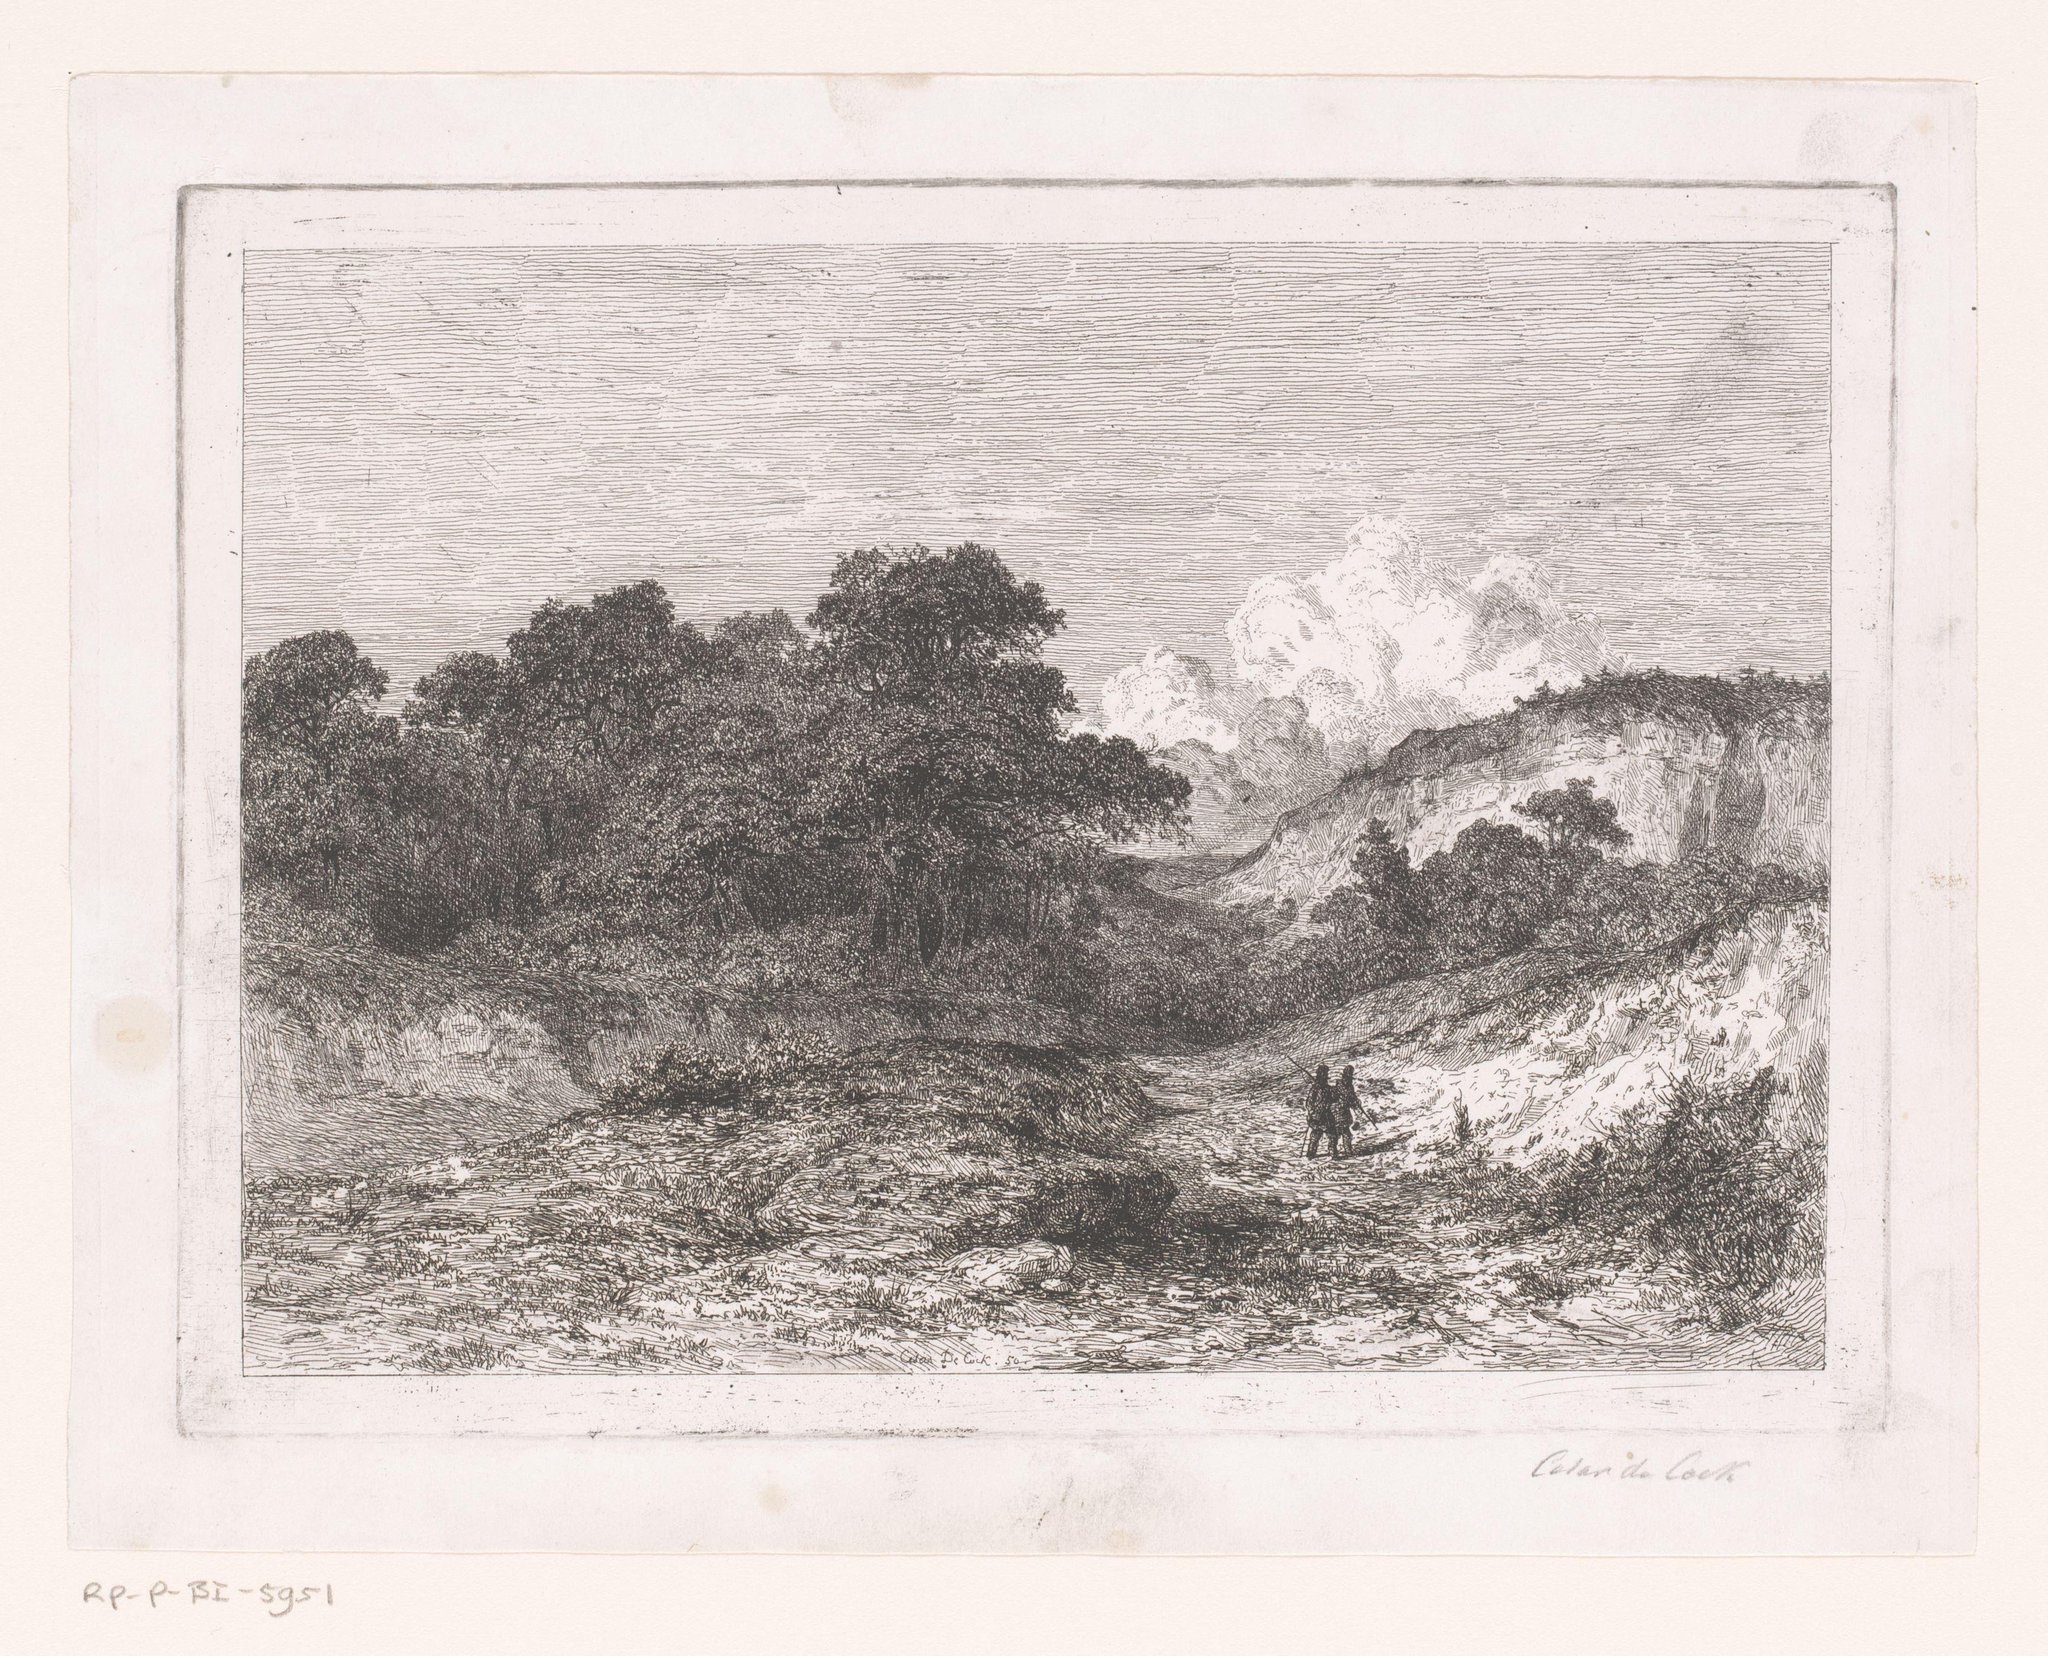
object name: print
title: Heuvellandschap met bebossing en twee figuren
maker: césar de cock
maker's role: print maker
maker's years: 1823-1904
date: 1850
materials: paper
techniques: etching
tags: (high) hill, forest, wood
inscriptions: date